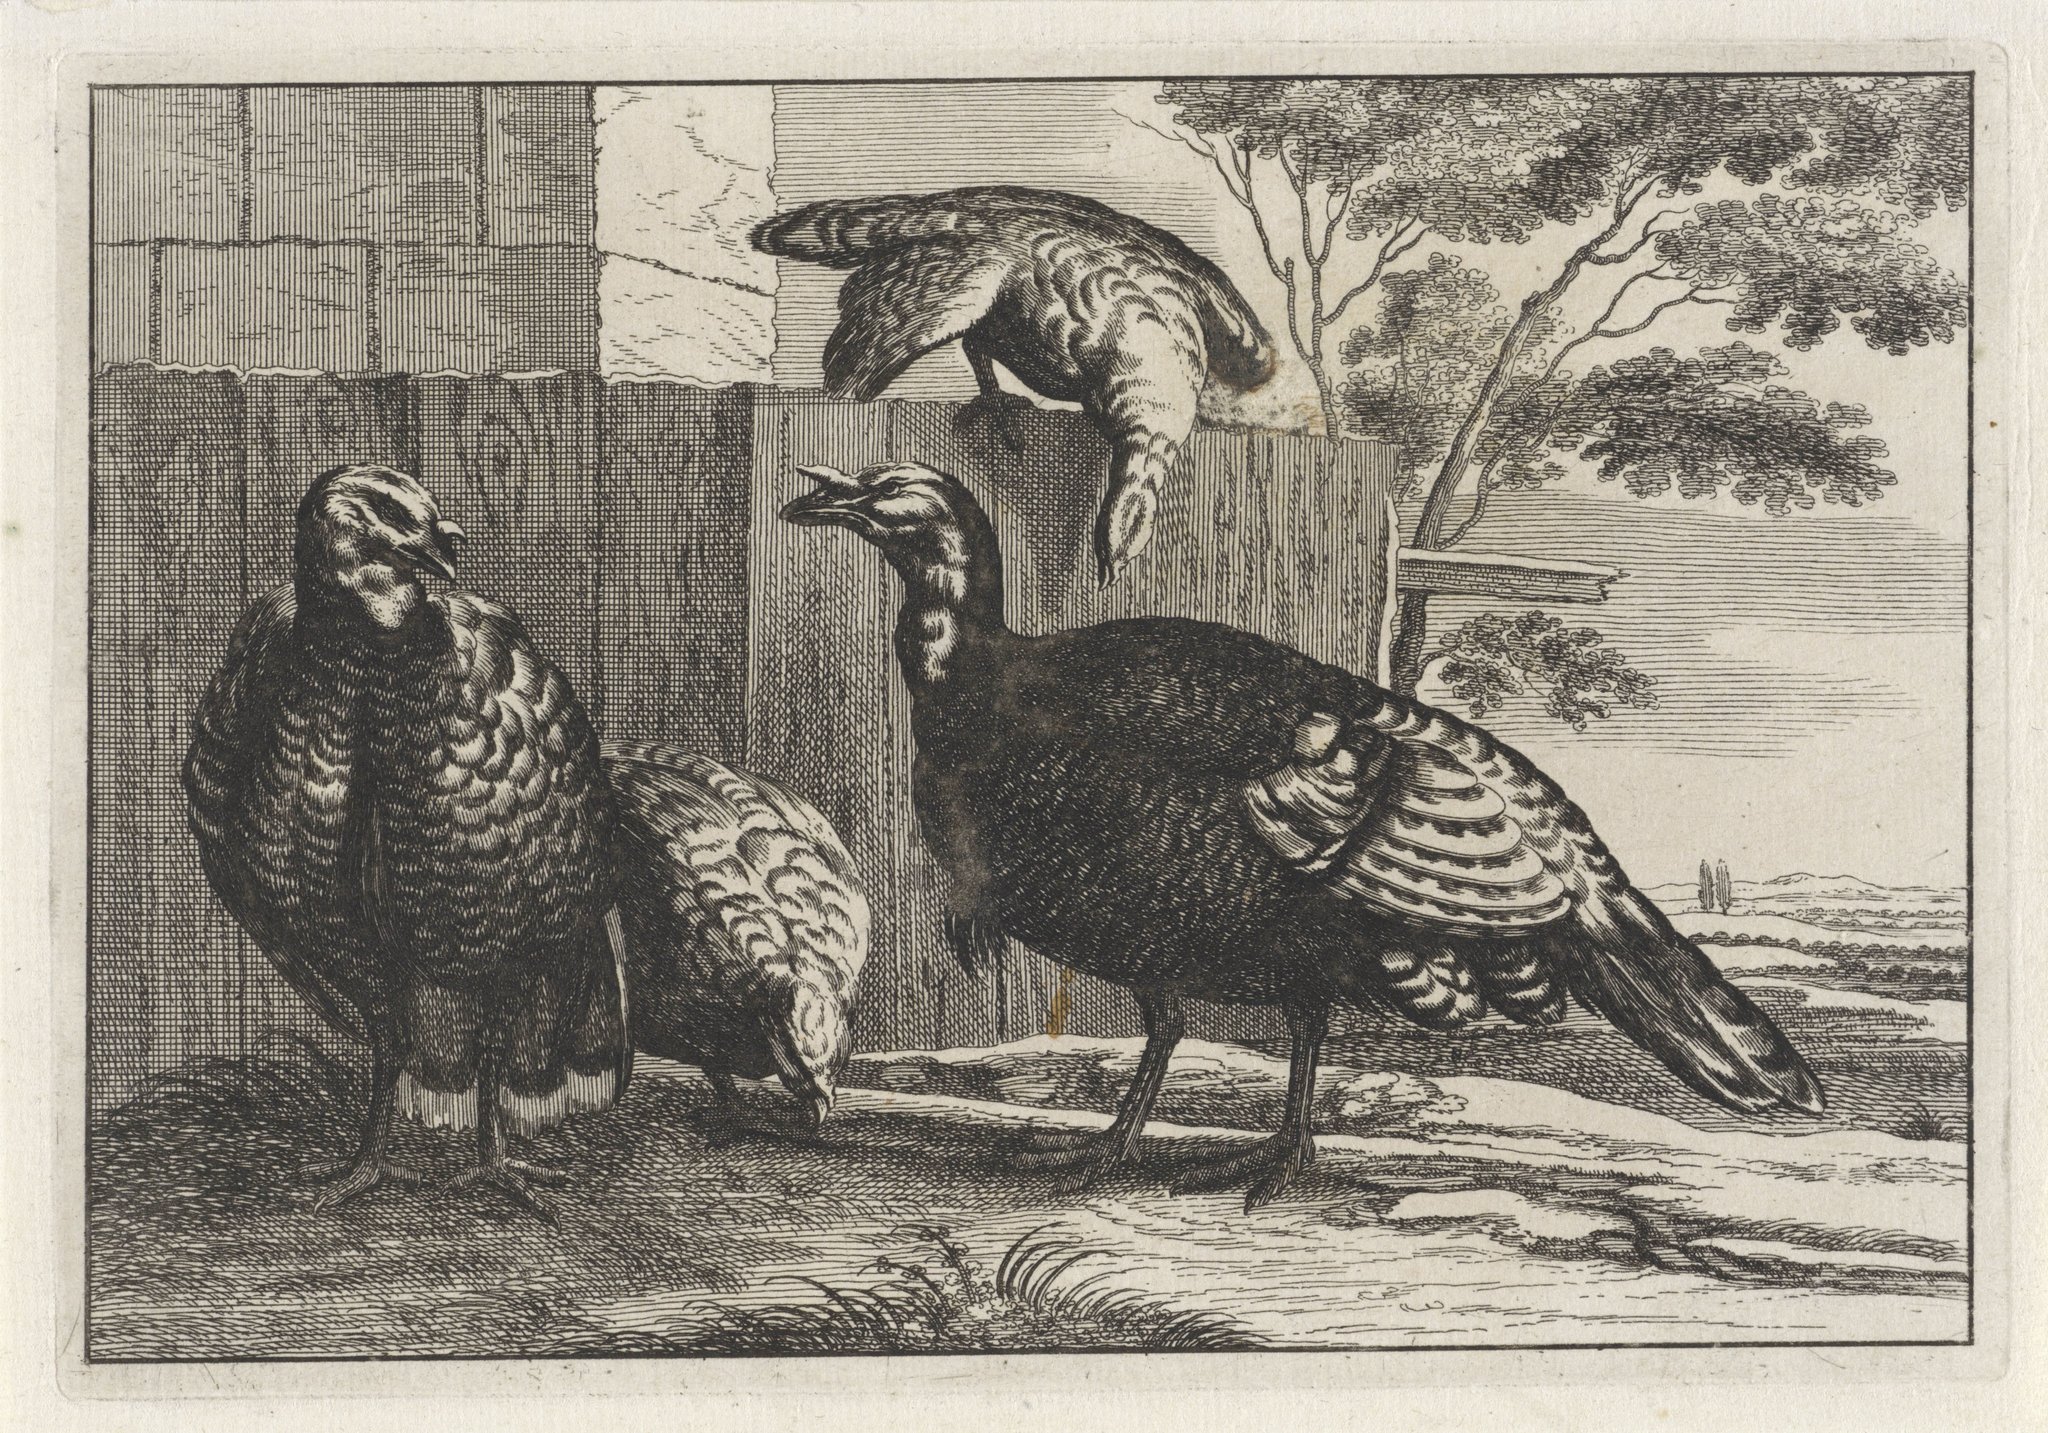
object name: print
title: Vier kalkoenen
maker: Anonymous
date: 1654-1712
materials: paper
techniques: etching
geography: england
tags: walker and runner birds: turkey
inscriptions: collector's mark: Lugt 2228, collector's mark: Lugt 2760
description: Kopie naar prent die deel uitmaakt van de negendelige serie met voorstellingen van verschillende vogels: "Diversae avium species".